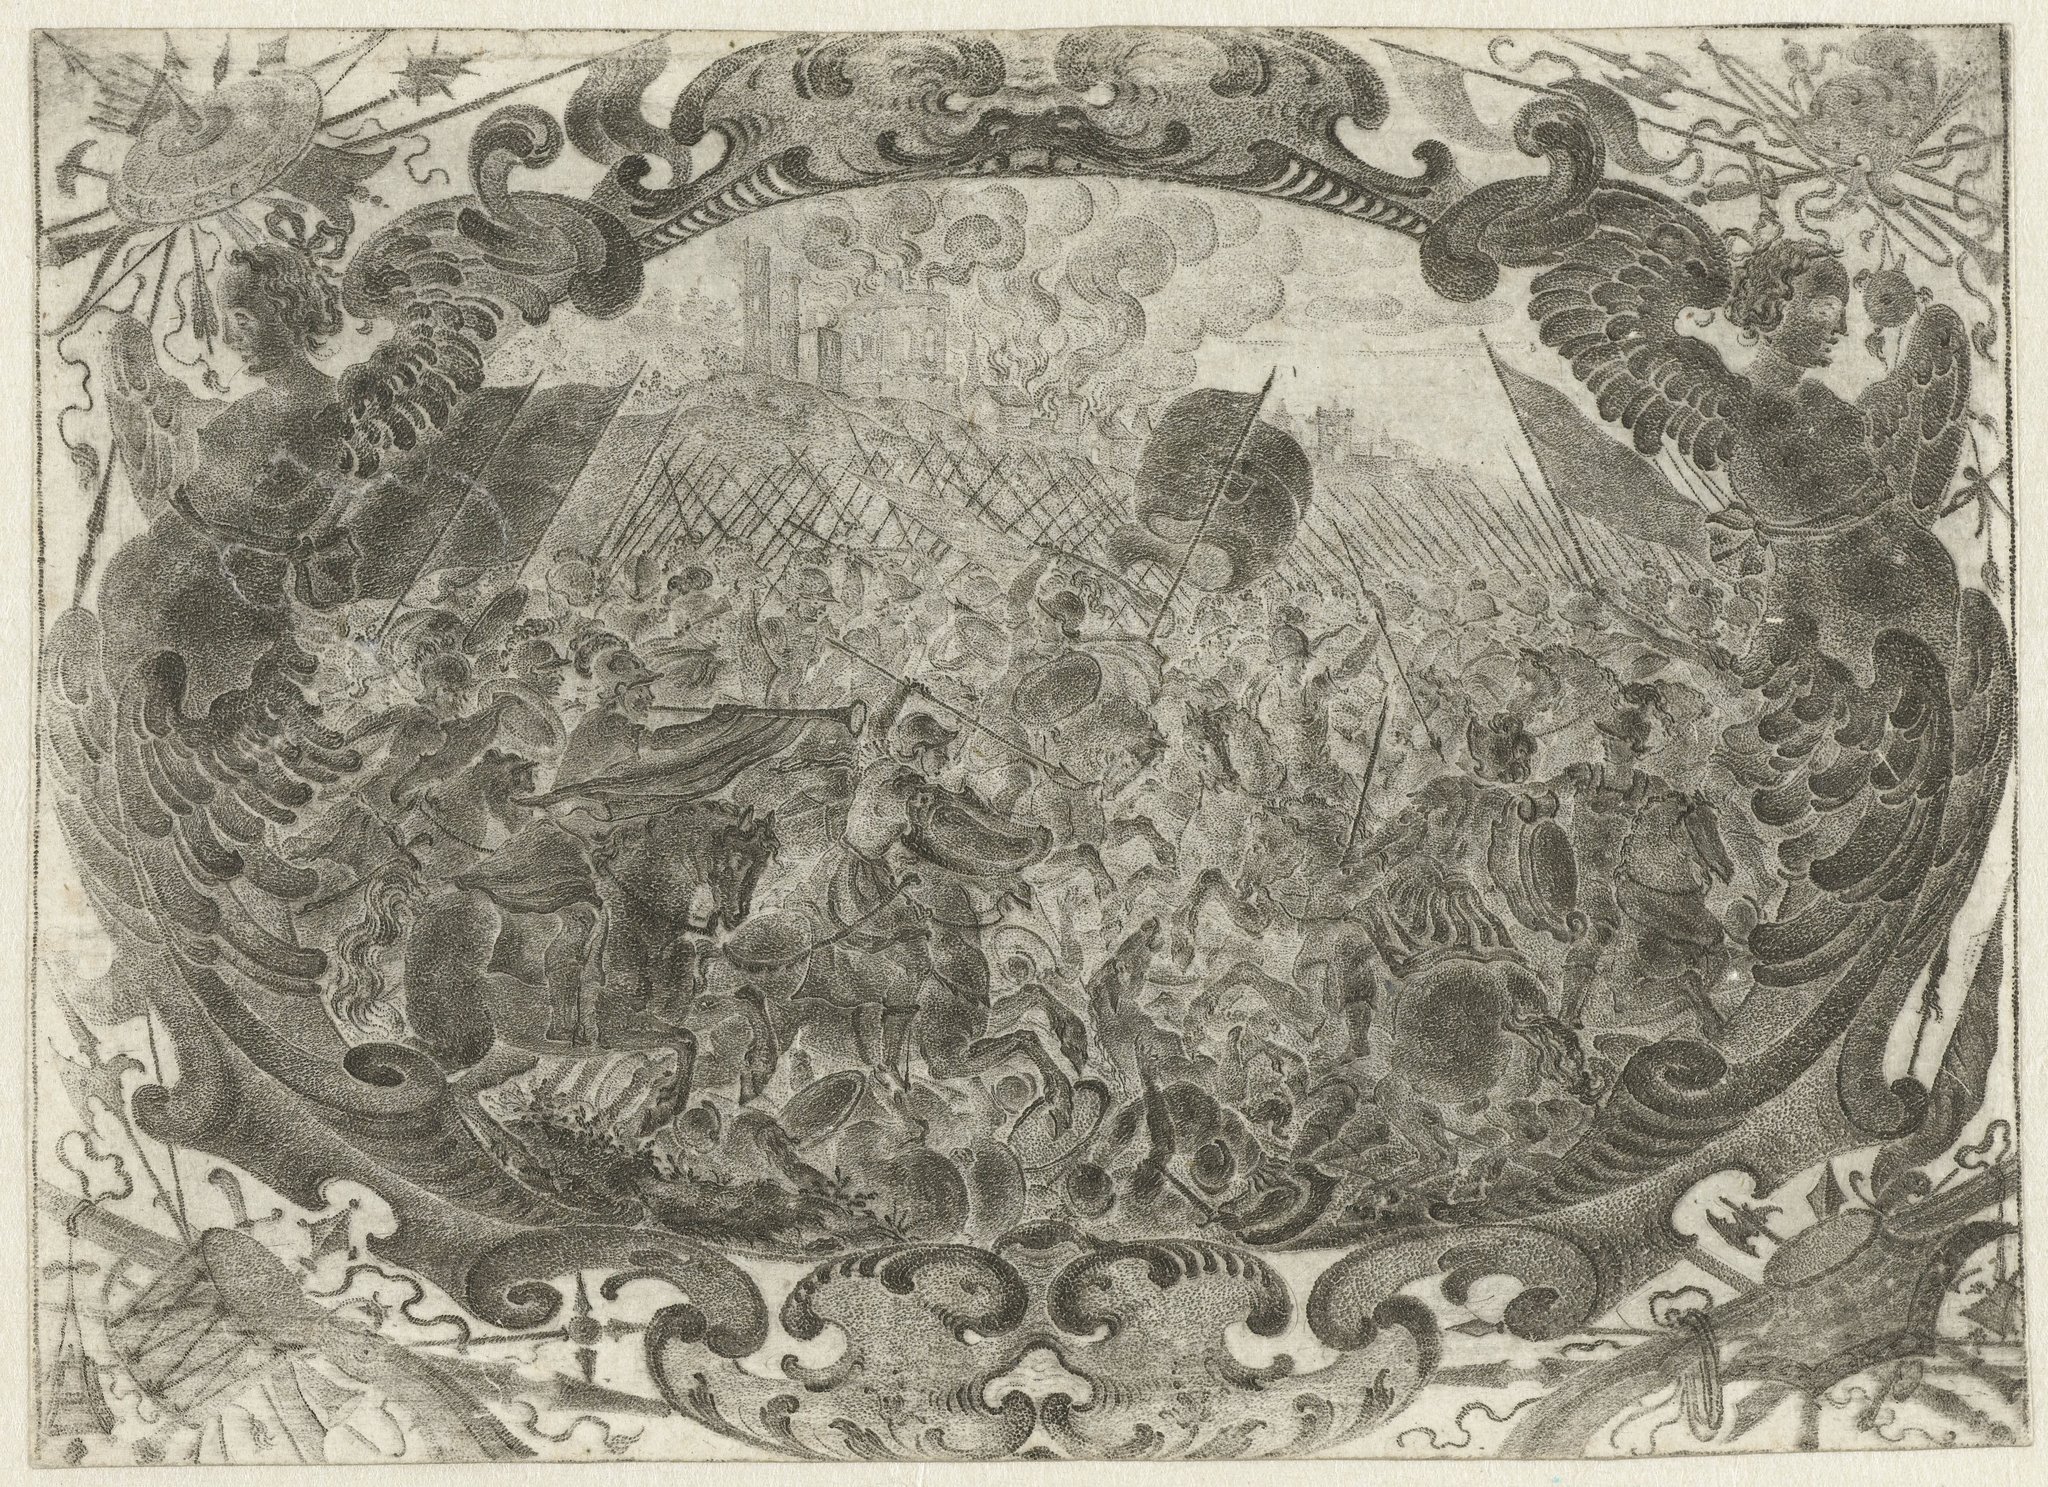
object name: ornament print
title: Cartouche met veldslag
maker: daniël kellerthaler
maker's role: print maker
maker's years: 1574-1665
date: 1630-1635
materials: paper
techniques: engraving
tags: battle, ornament ~ cartouche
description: Cartouche met veldslag van twee legers met ruiters en voetvolk. In de vier hoeken wapentrofëen.